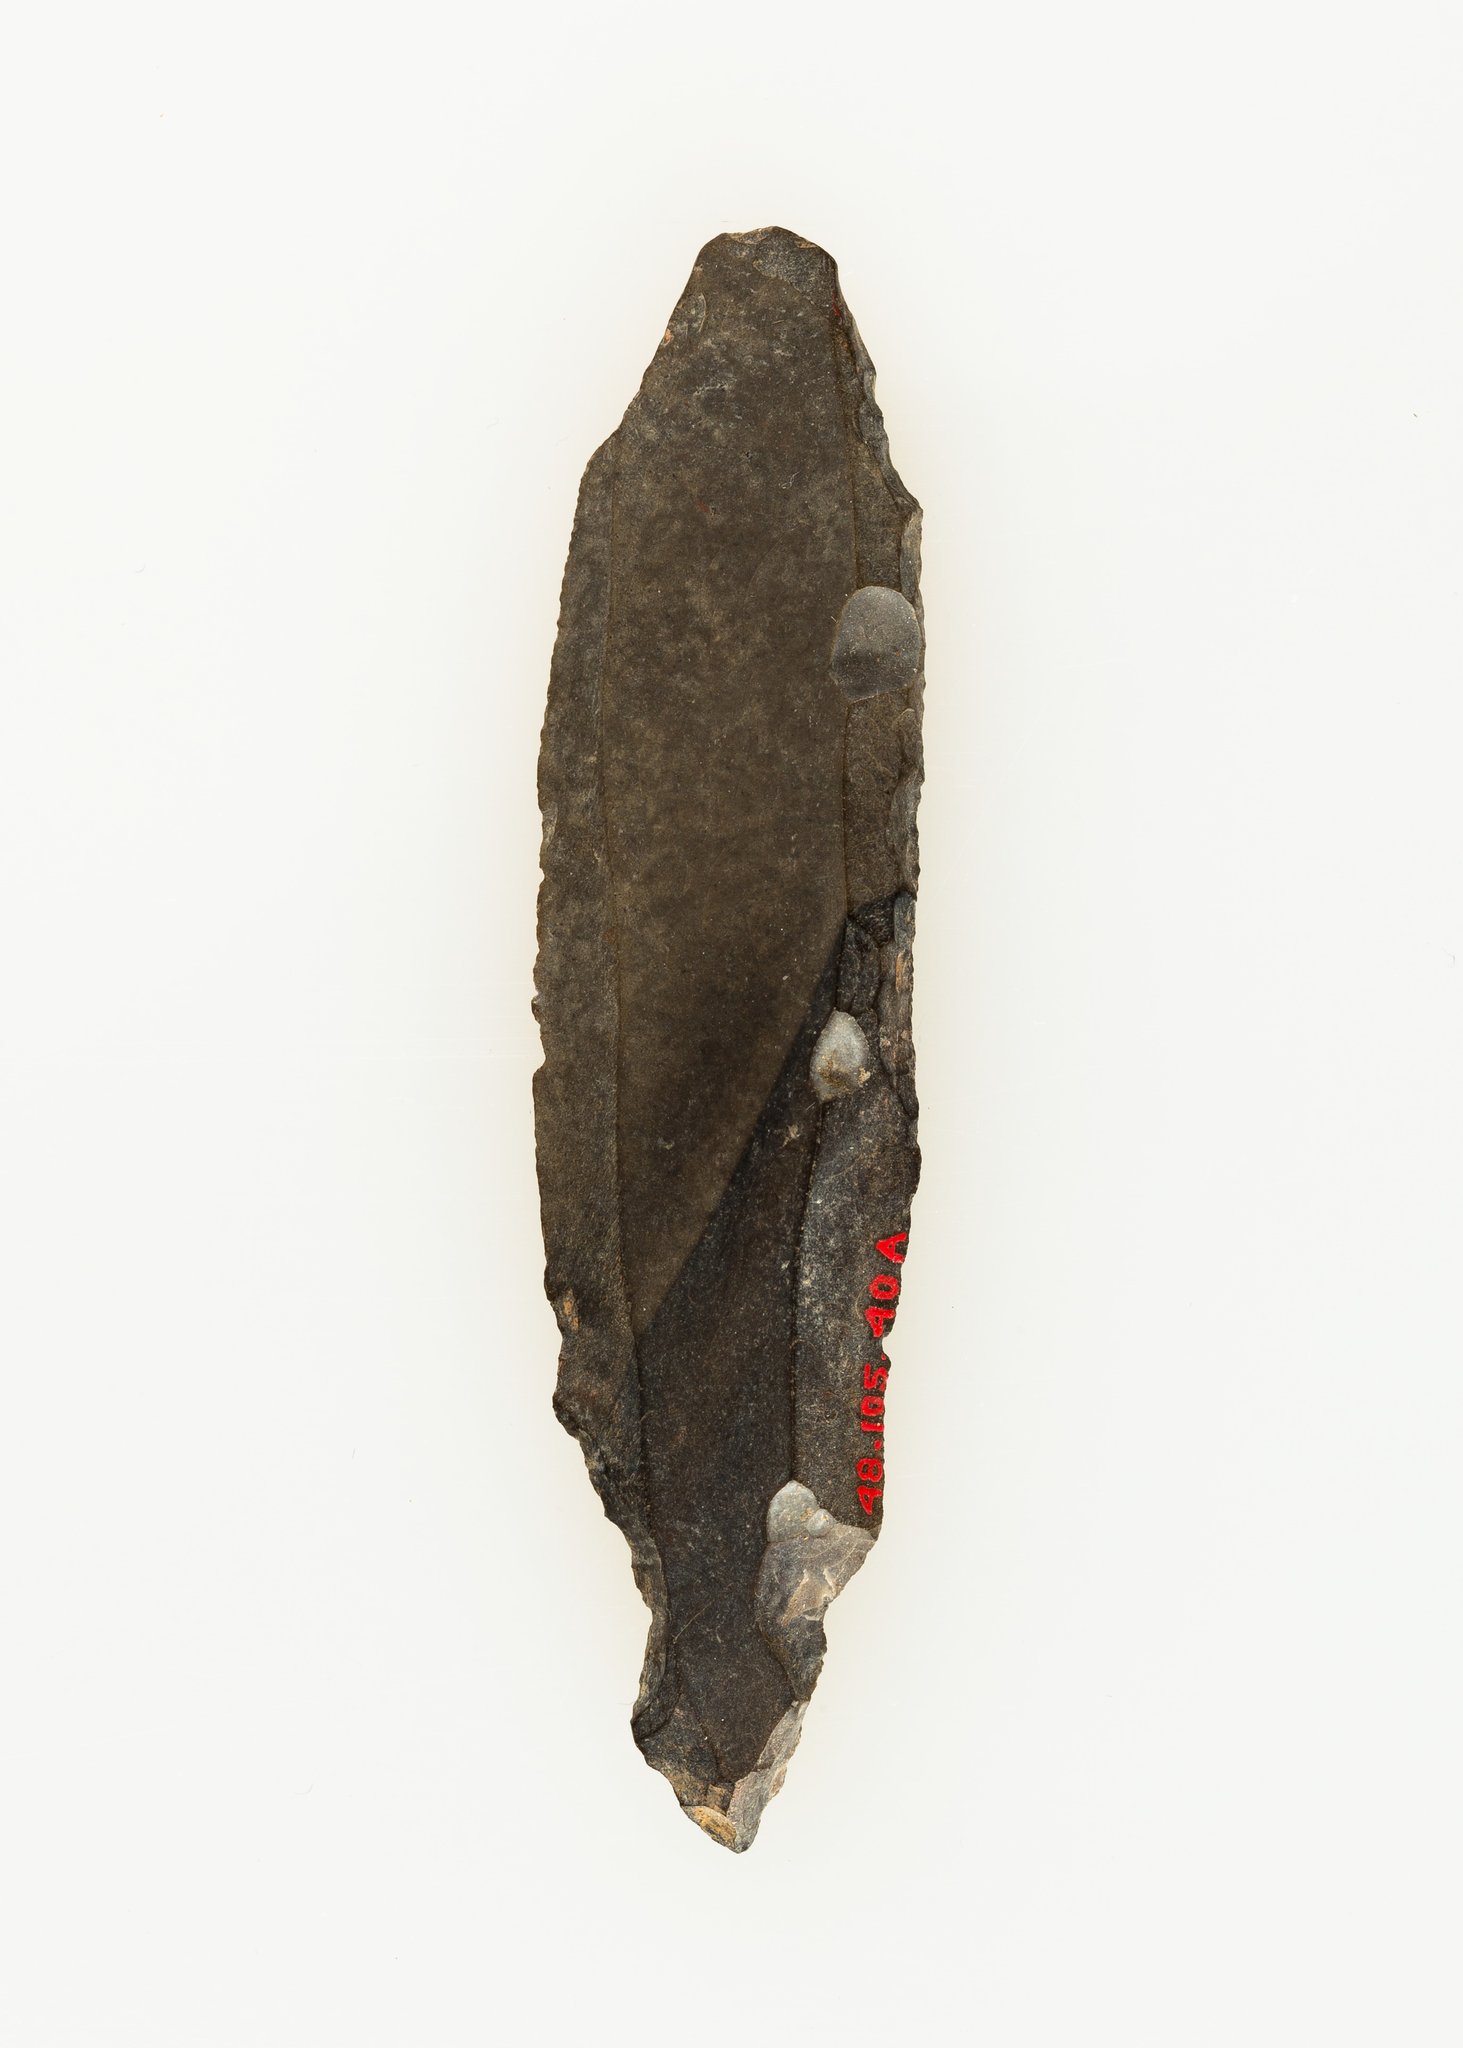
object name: tanged, tool, projectile, point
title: Tanged Tool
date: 1184-664 BCE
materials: stone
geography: egypt